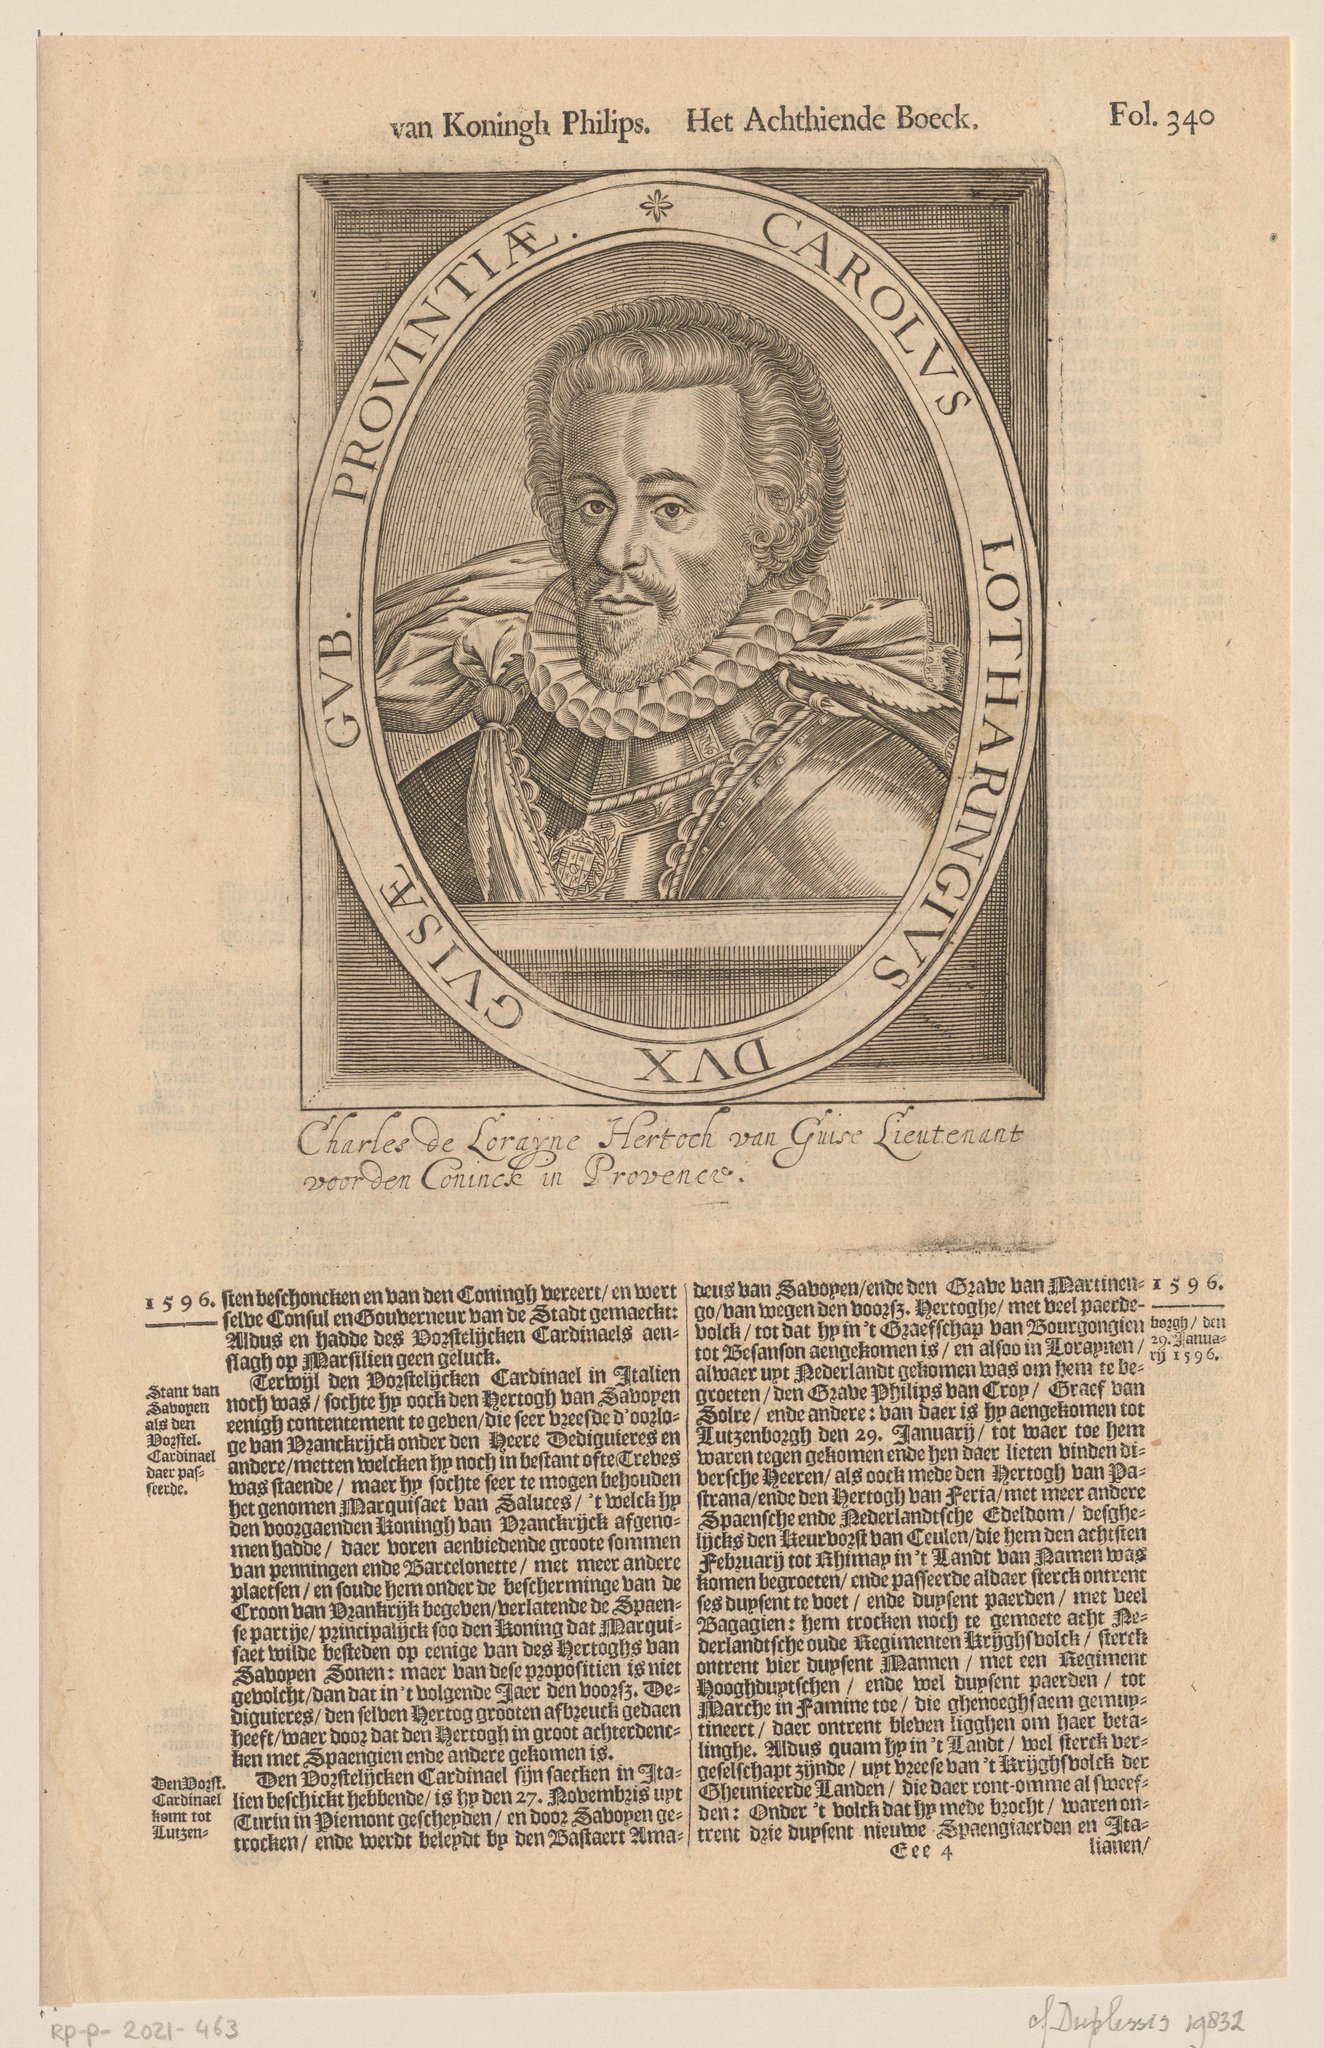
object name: book illustration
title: Portret van Karel I, hertog de Guise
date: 1647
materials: paper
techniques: engraving, etching, letterpress printing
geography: rotterdam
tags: historical persons, officer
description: Prent uit: Meteren, Emmanuel van. Historien der Nederlanden, en haar naburen oorlogen tot het iaar 1612. Rotterdam: Pieter van Waesberge, 1647.